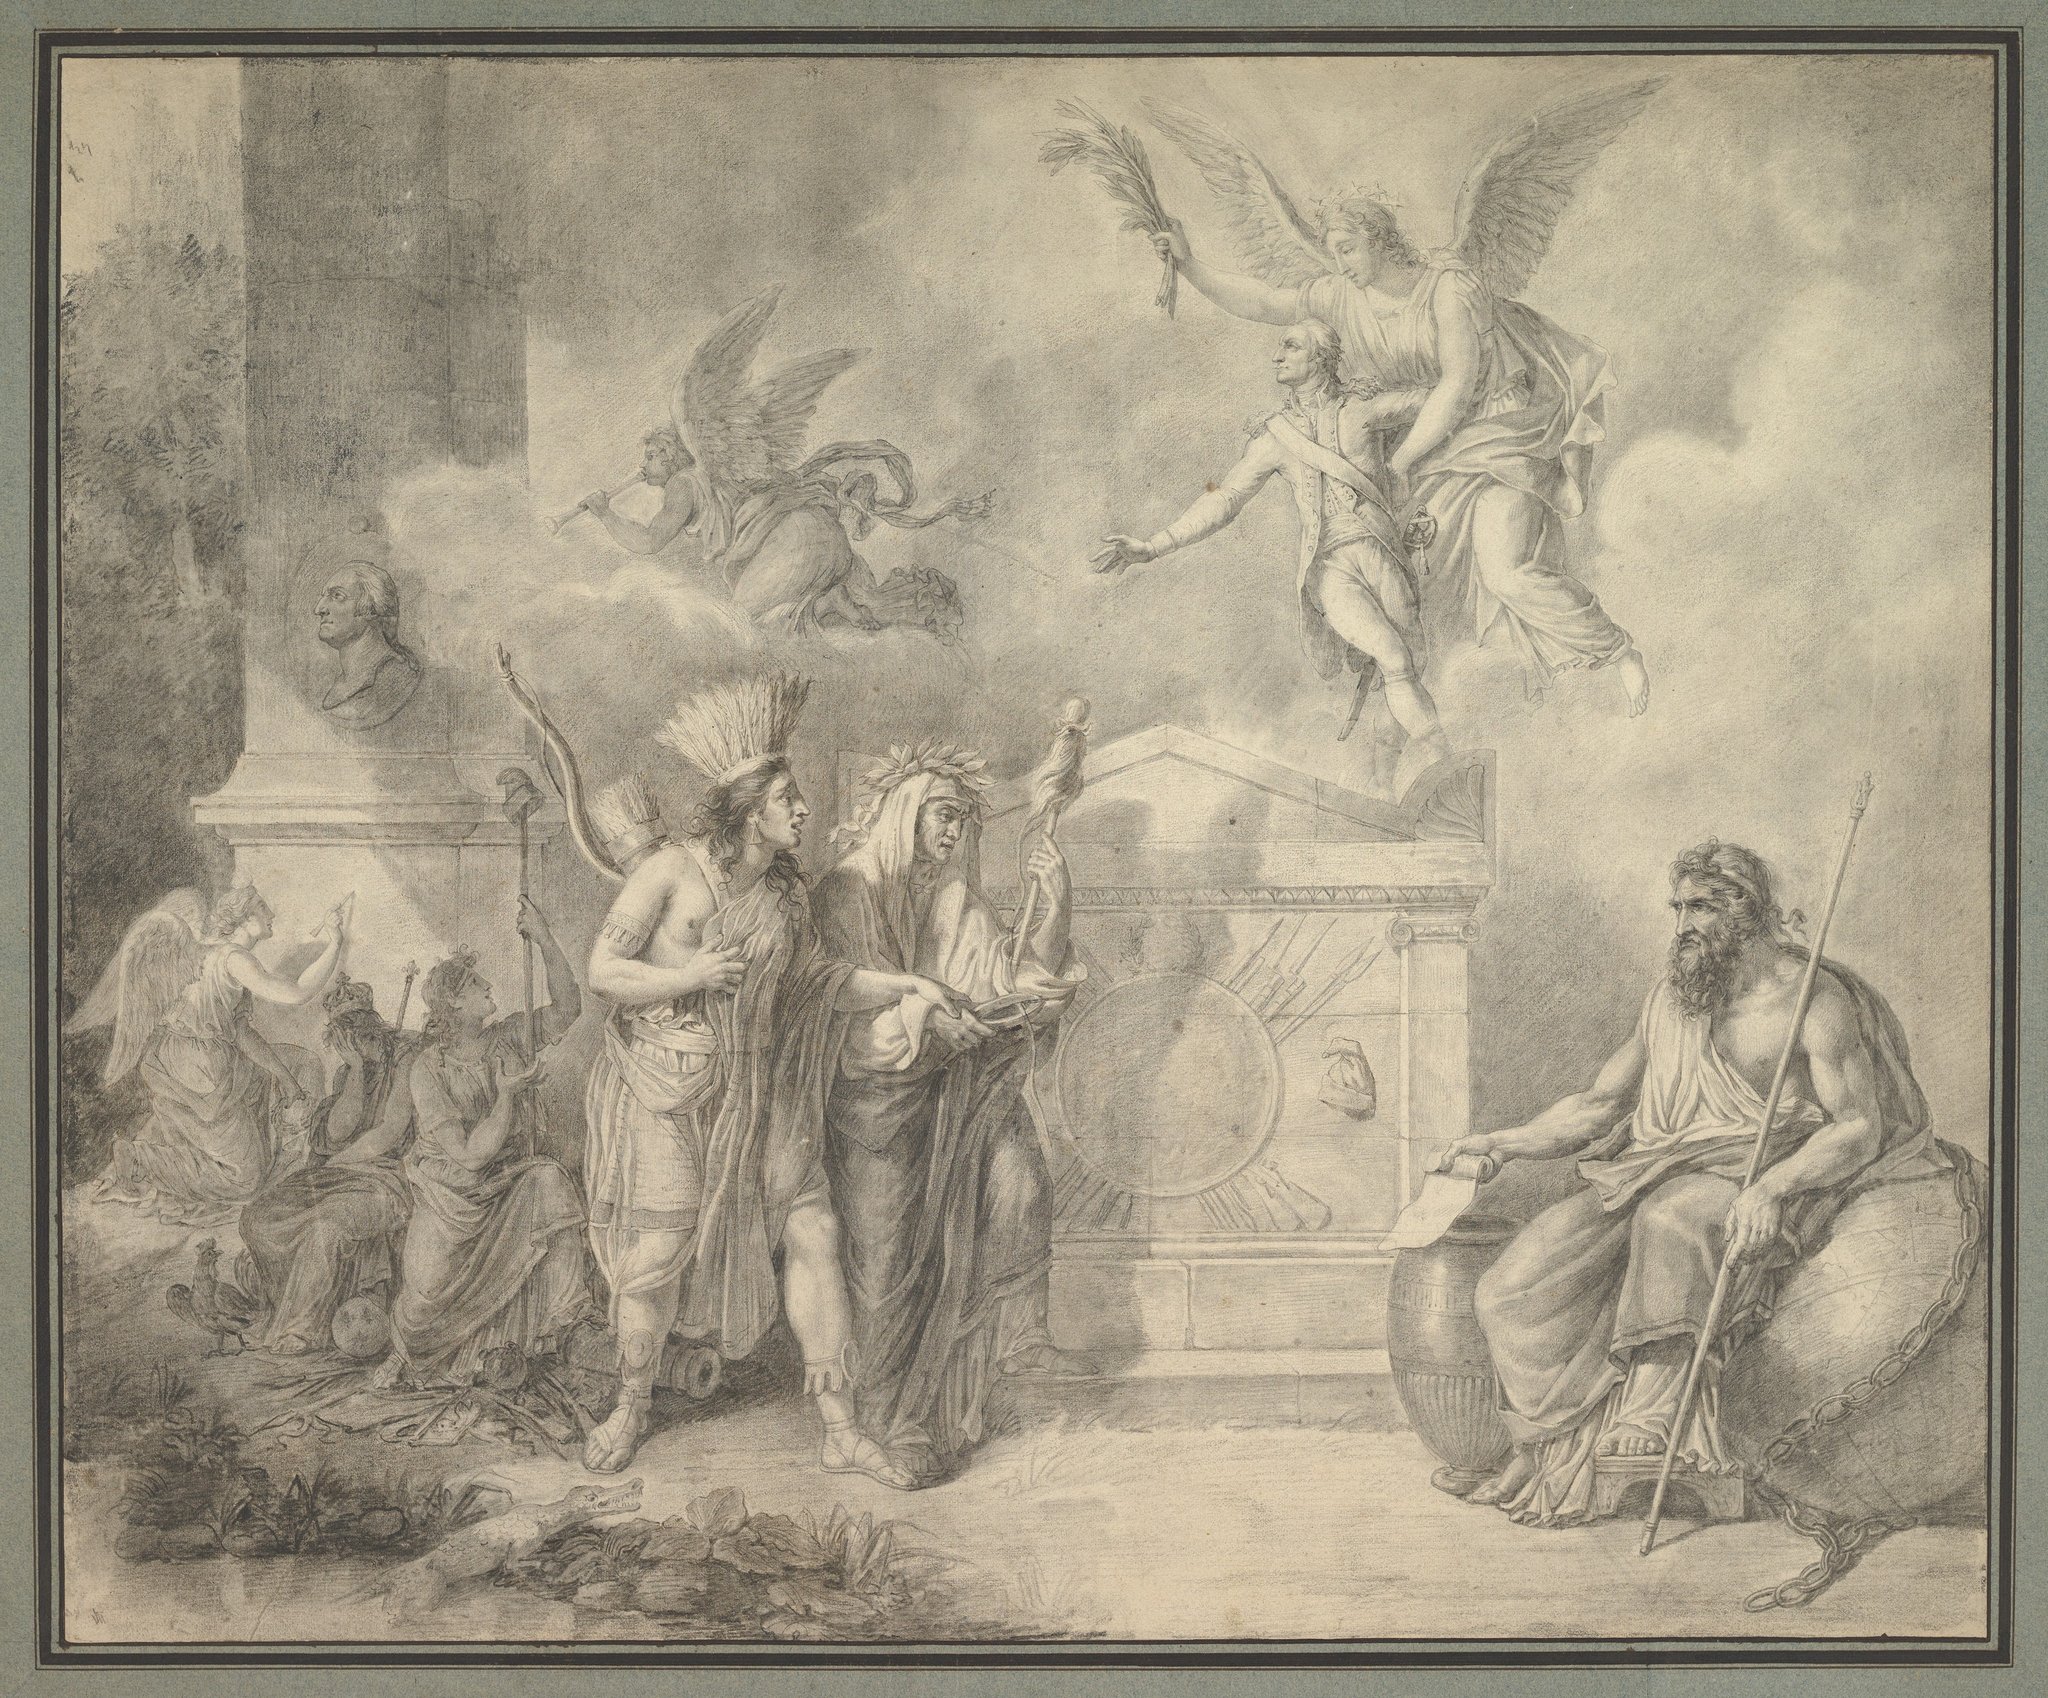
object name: drawing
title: Apotheosis of George Washington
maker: etienne pallière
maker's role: artist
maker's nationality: french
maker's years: 1761-1820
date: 1799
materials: chalk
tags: weapons,george washington,zeus,victory,angels